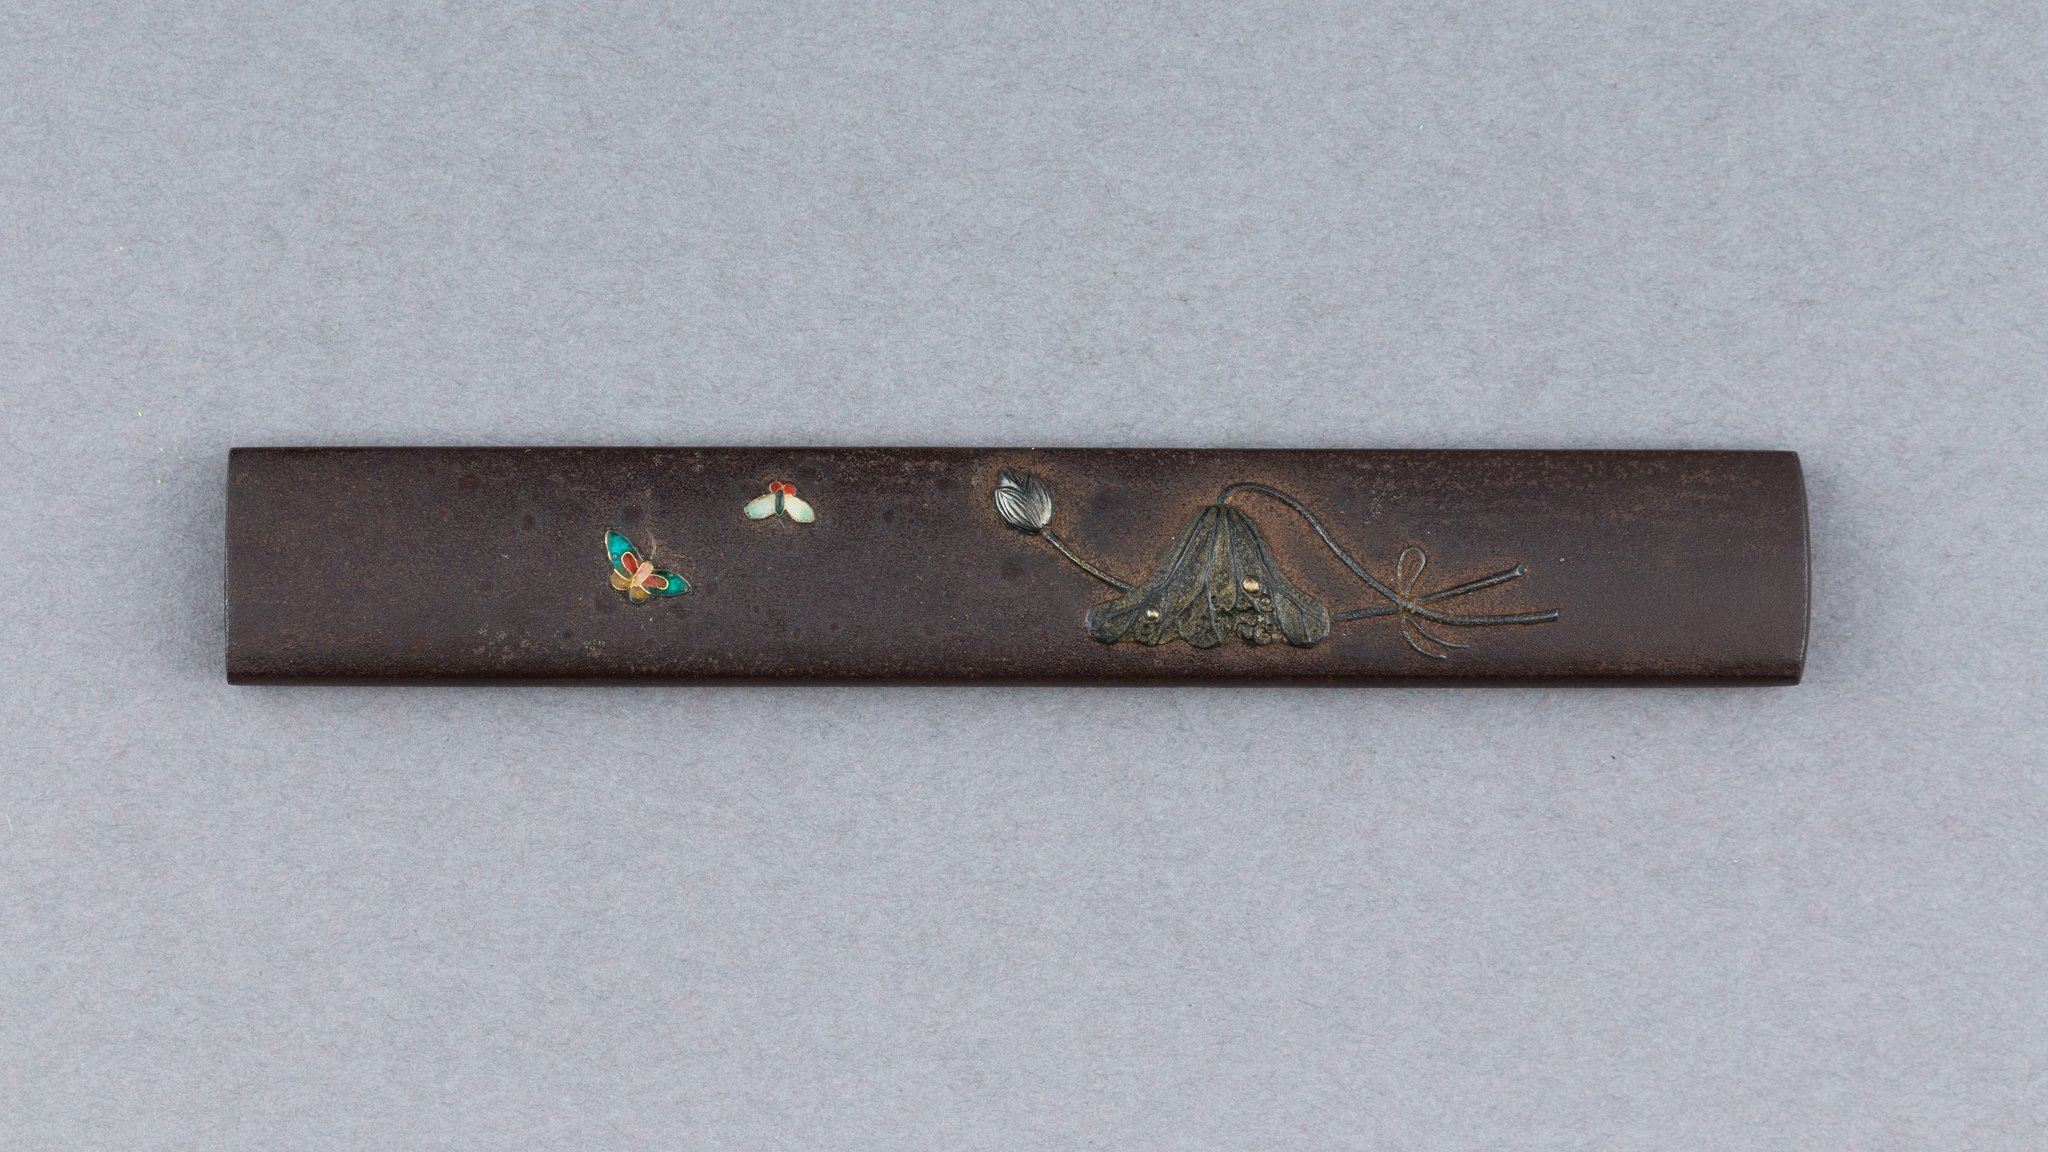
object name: knife handle kozuka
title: Knife Handle (Kozuka)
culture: japanese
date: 1615-1868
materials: gold alloy, silver alloy, iron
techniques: enamel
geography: japan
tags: butterflies